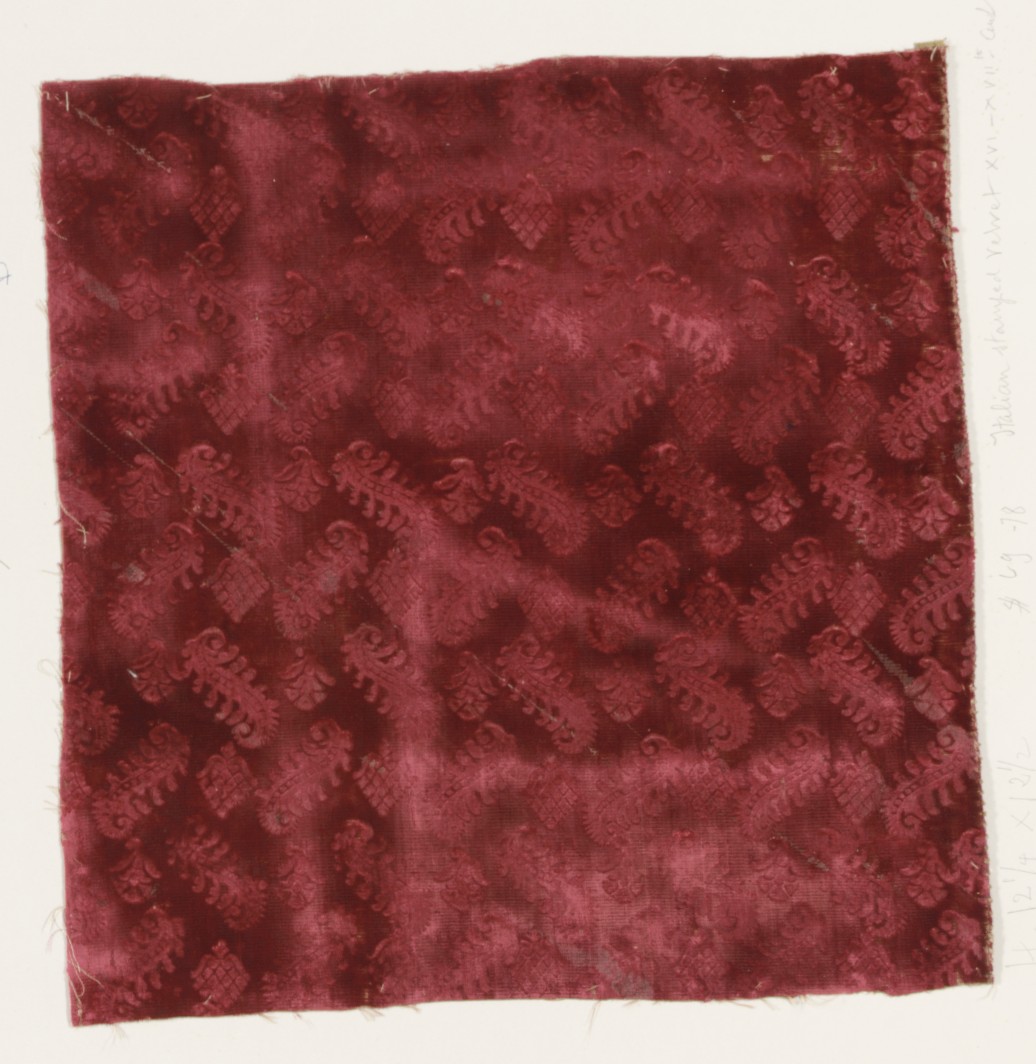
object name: fragment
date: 1501-1700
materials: silk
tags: leaves